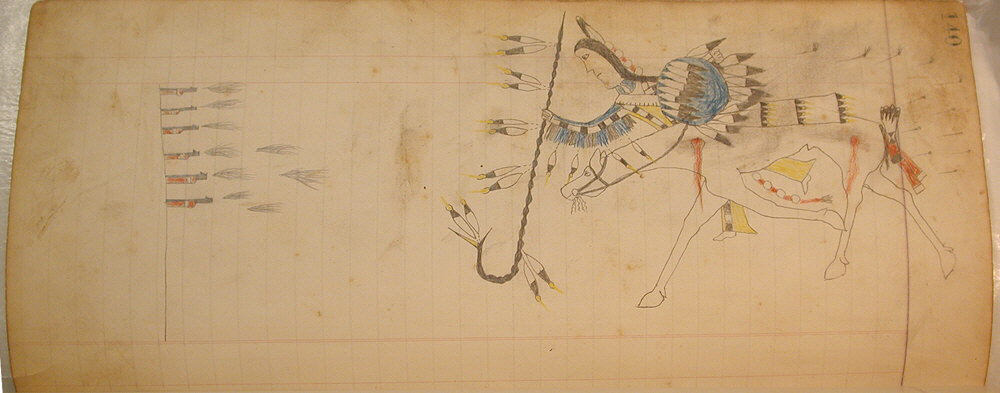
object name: drawing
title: Maffet Ledger: Drawing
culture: cheyenne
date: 1874-1881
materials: crayon, graphite, paper, watercolor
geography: united states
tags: men,horses